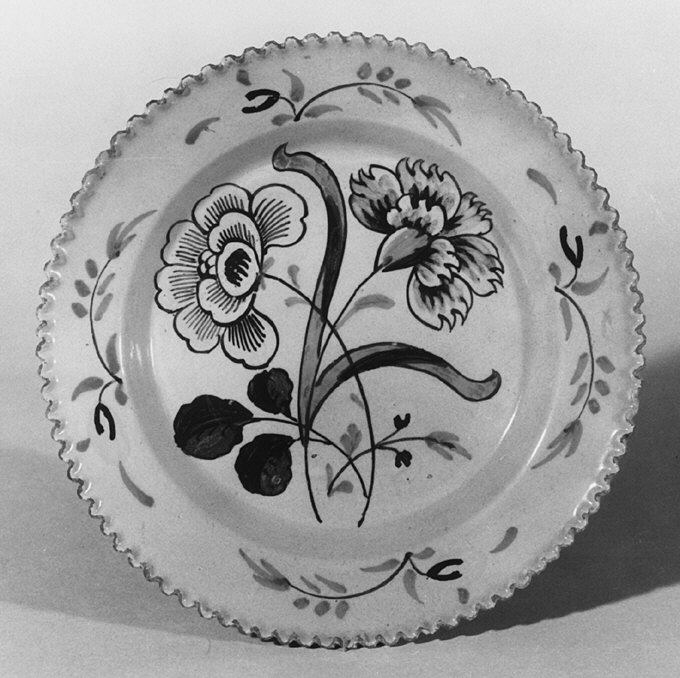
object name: dish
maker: de porceleyne fles manufactory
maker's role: manufactory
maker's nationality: dutch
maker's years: 1653-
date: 1771-1786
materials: faience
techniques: glazing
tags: flowers